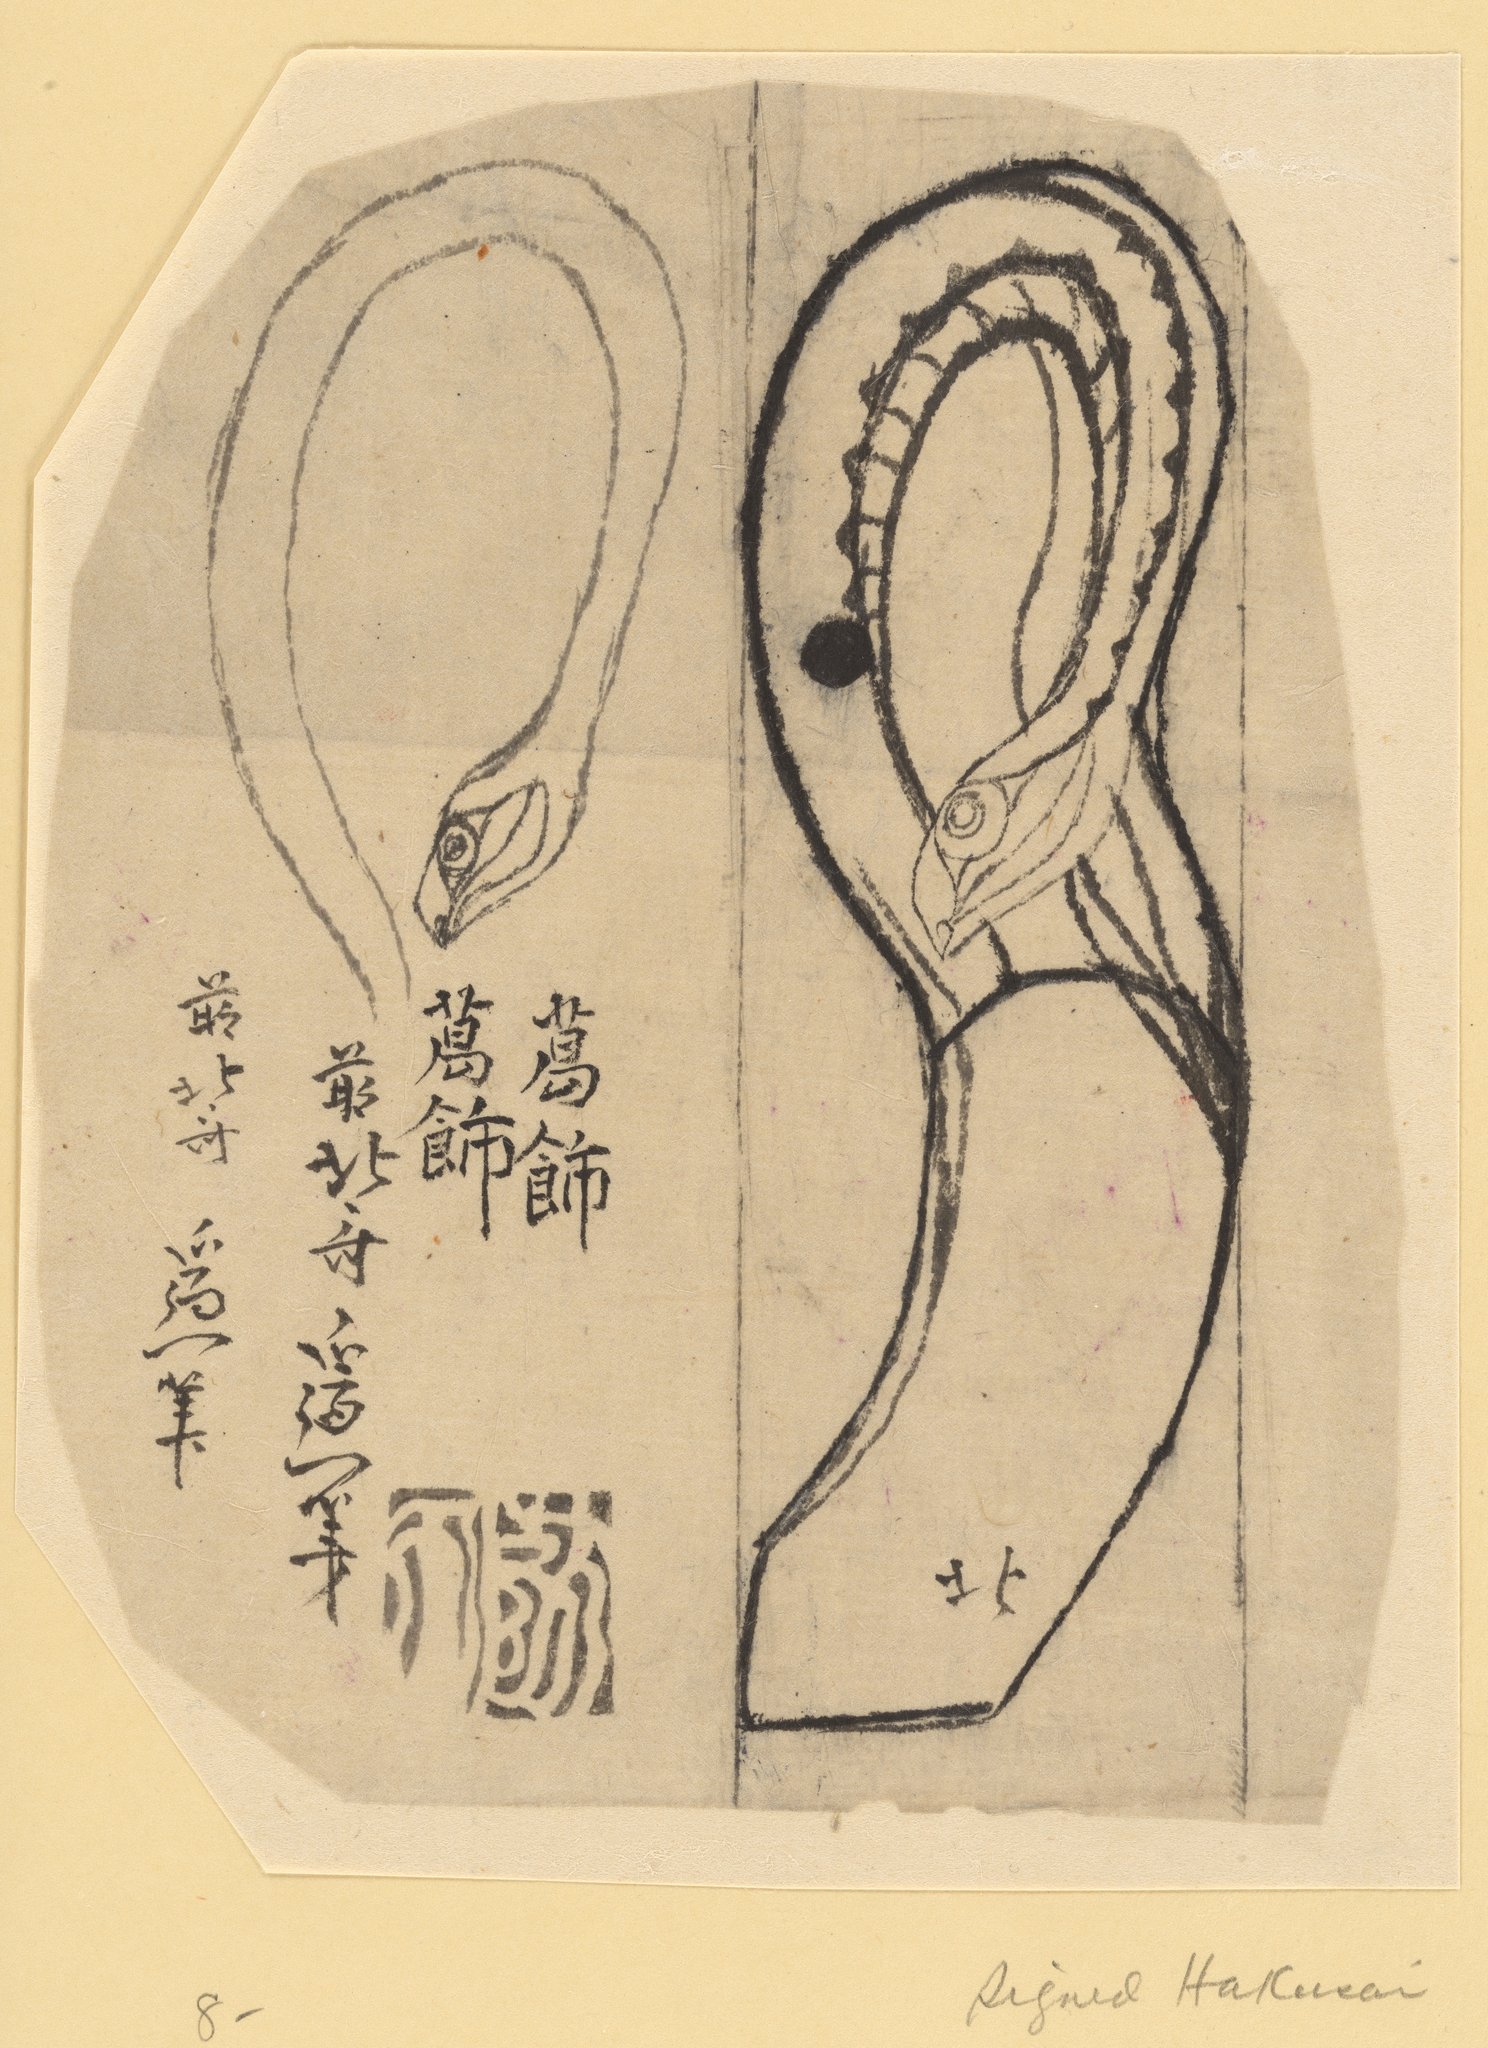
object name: drawing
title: Snake Heads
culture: japanese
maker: katsushika hokusai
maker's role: artist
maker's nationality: japanese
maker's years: 1760-1849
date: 1701-1900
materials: ink, paper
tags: snakes